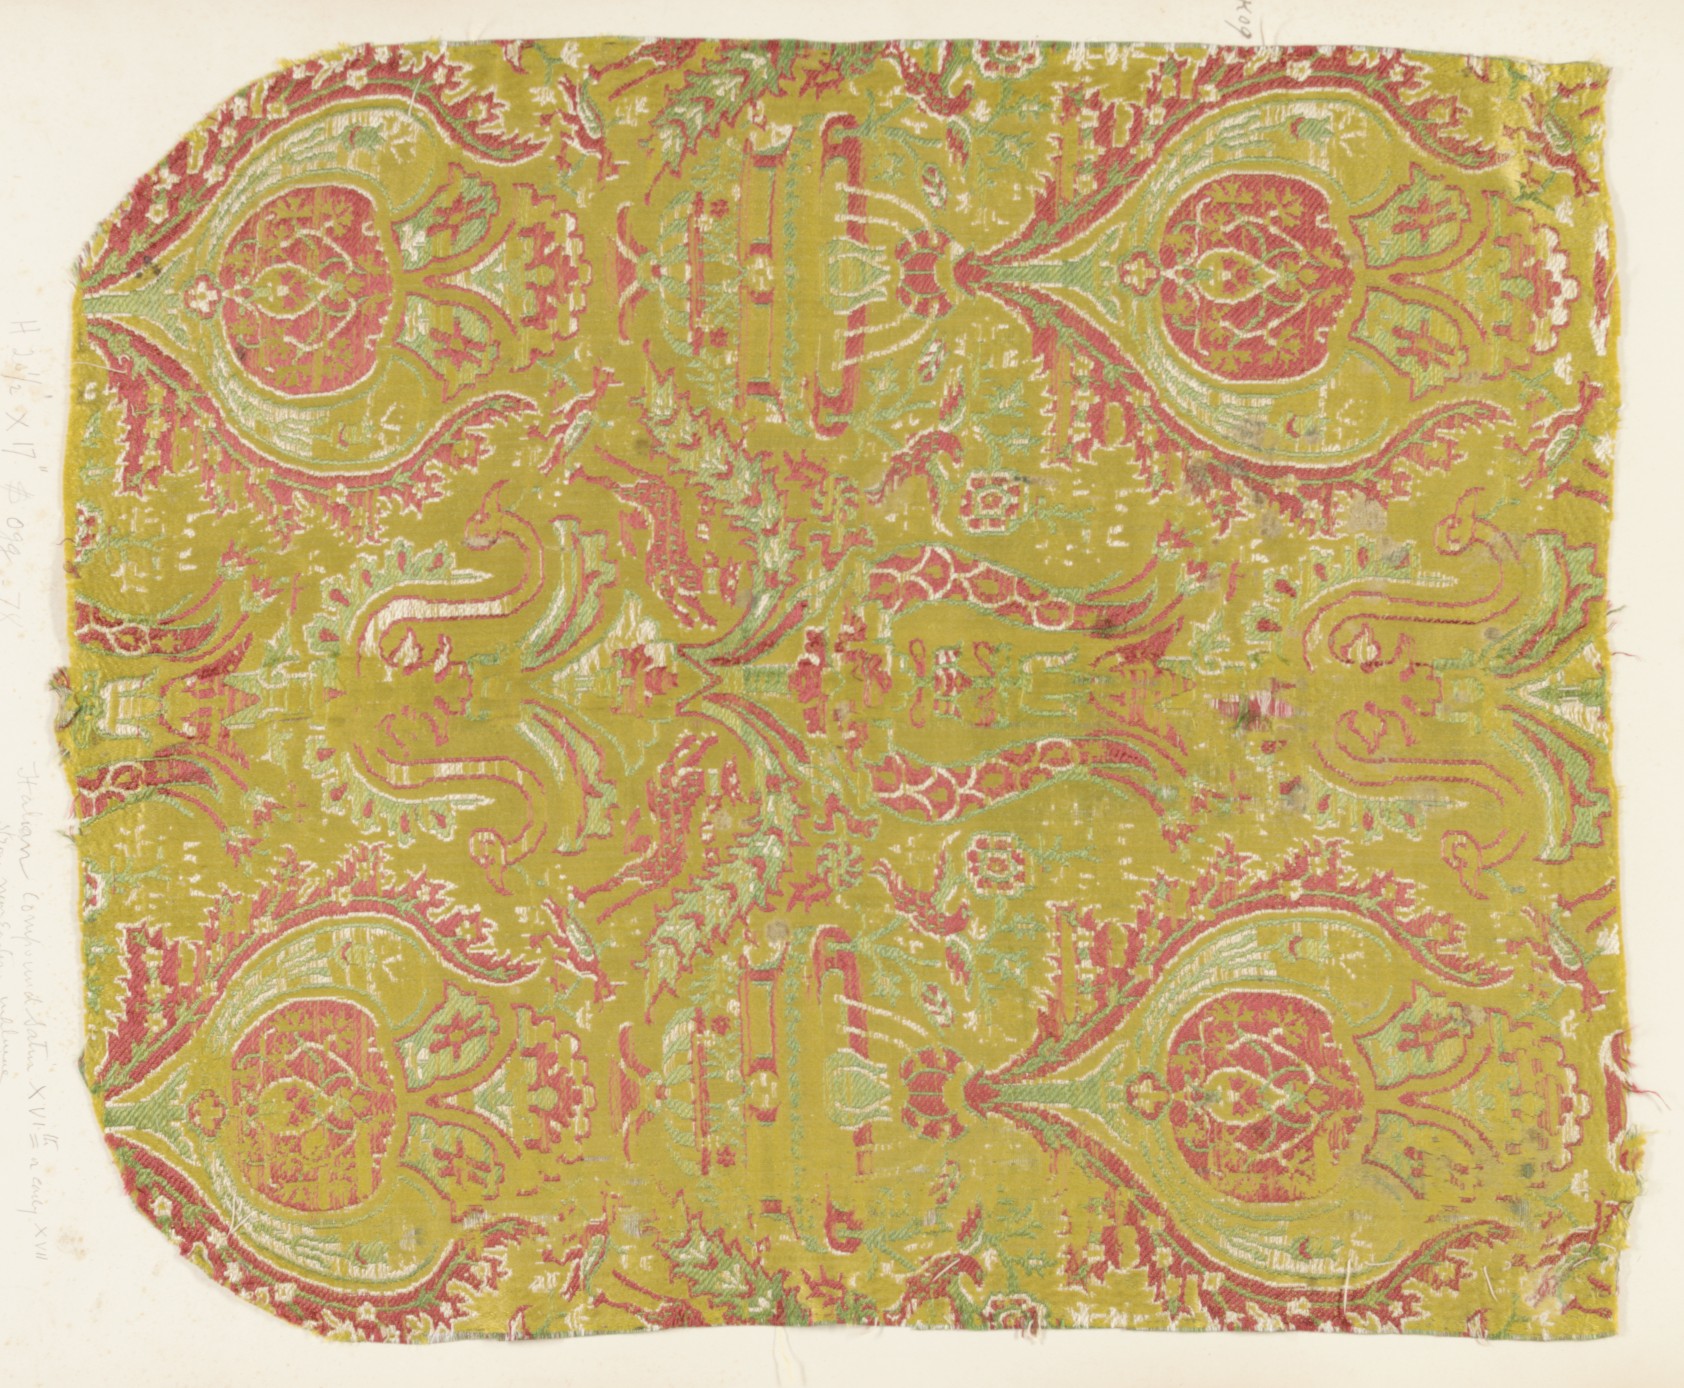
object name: fragment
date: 1501-1700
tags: animals,birds